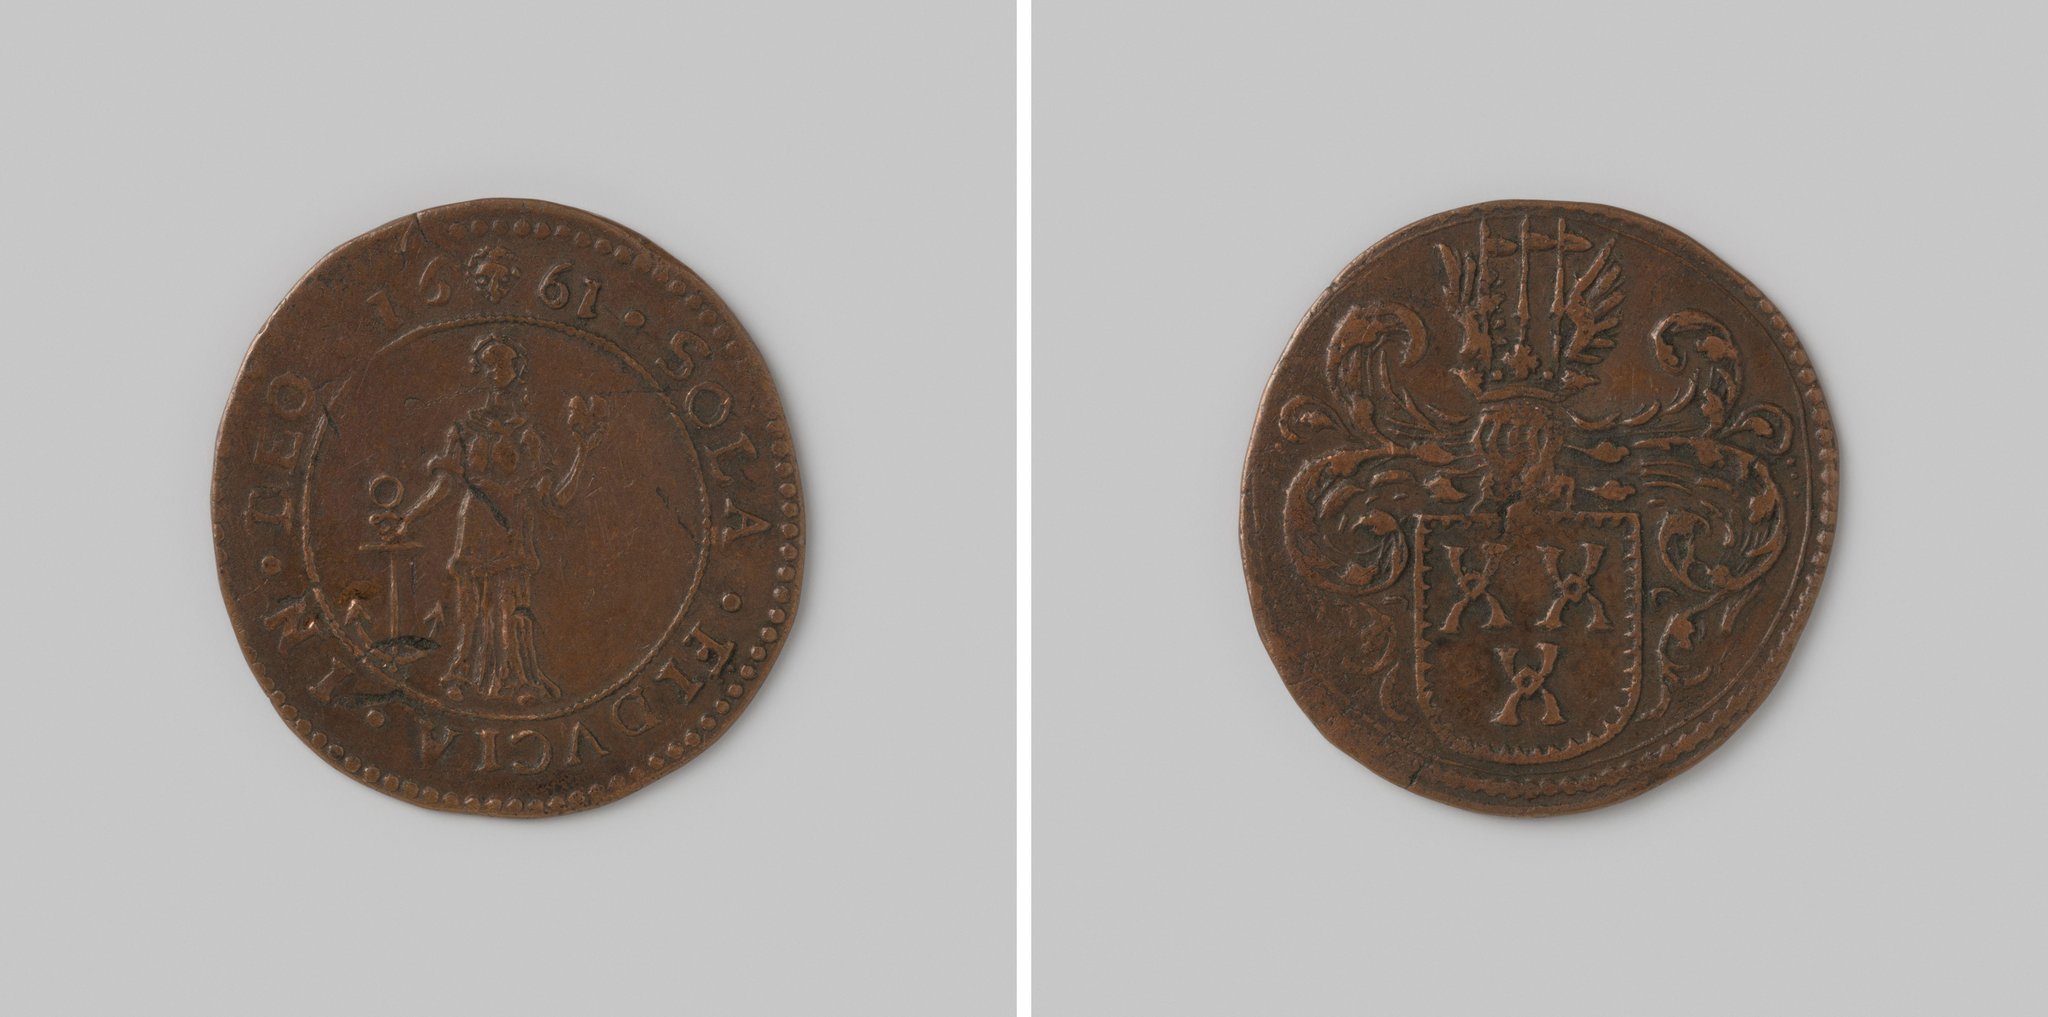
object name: jeton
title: Rekenpenning uit Brussel voor F. van Broeckhoven thesaurier van Brussel op het vertrouwen in God 1661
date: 1661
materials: copper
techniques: striking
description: Koperen penning, op de voorzijde Fortuna met anker en hart, met omschrift, op de keerzijde een gehelmd wapenschild met omschrift.